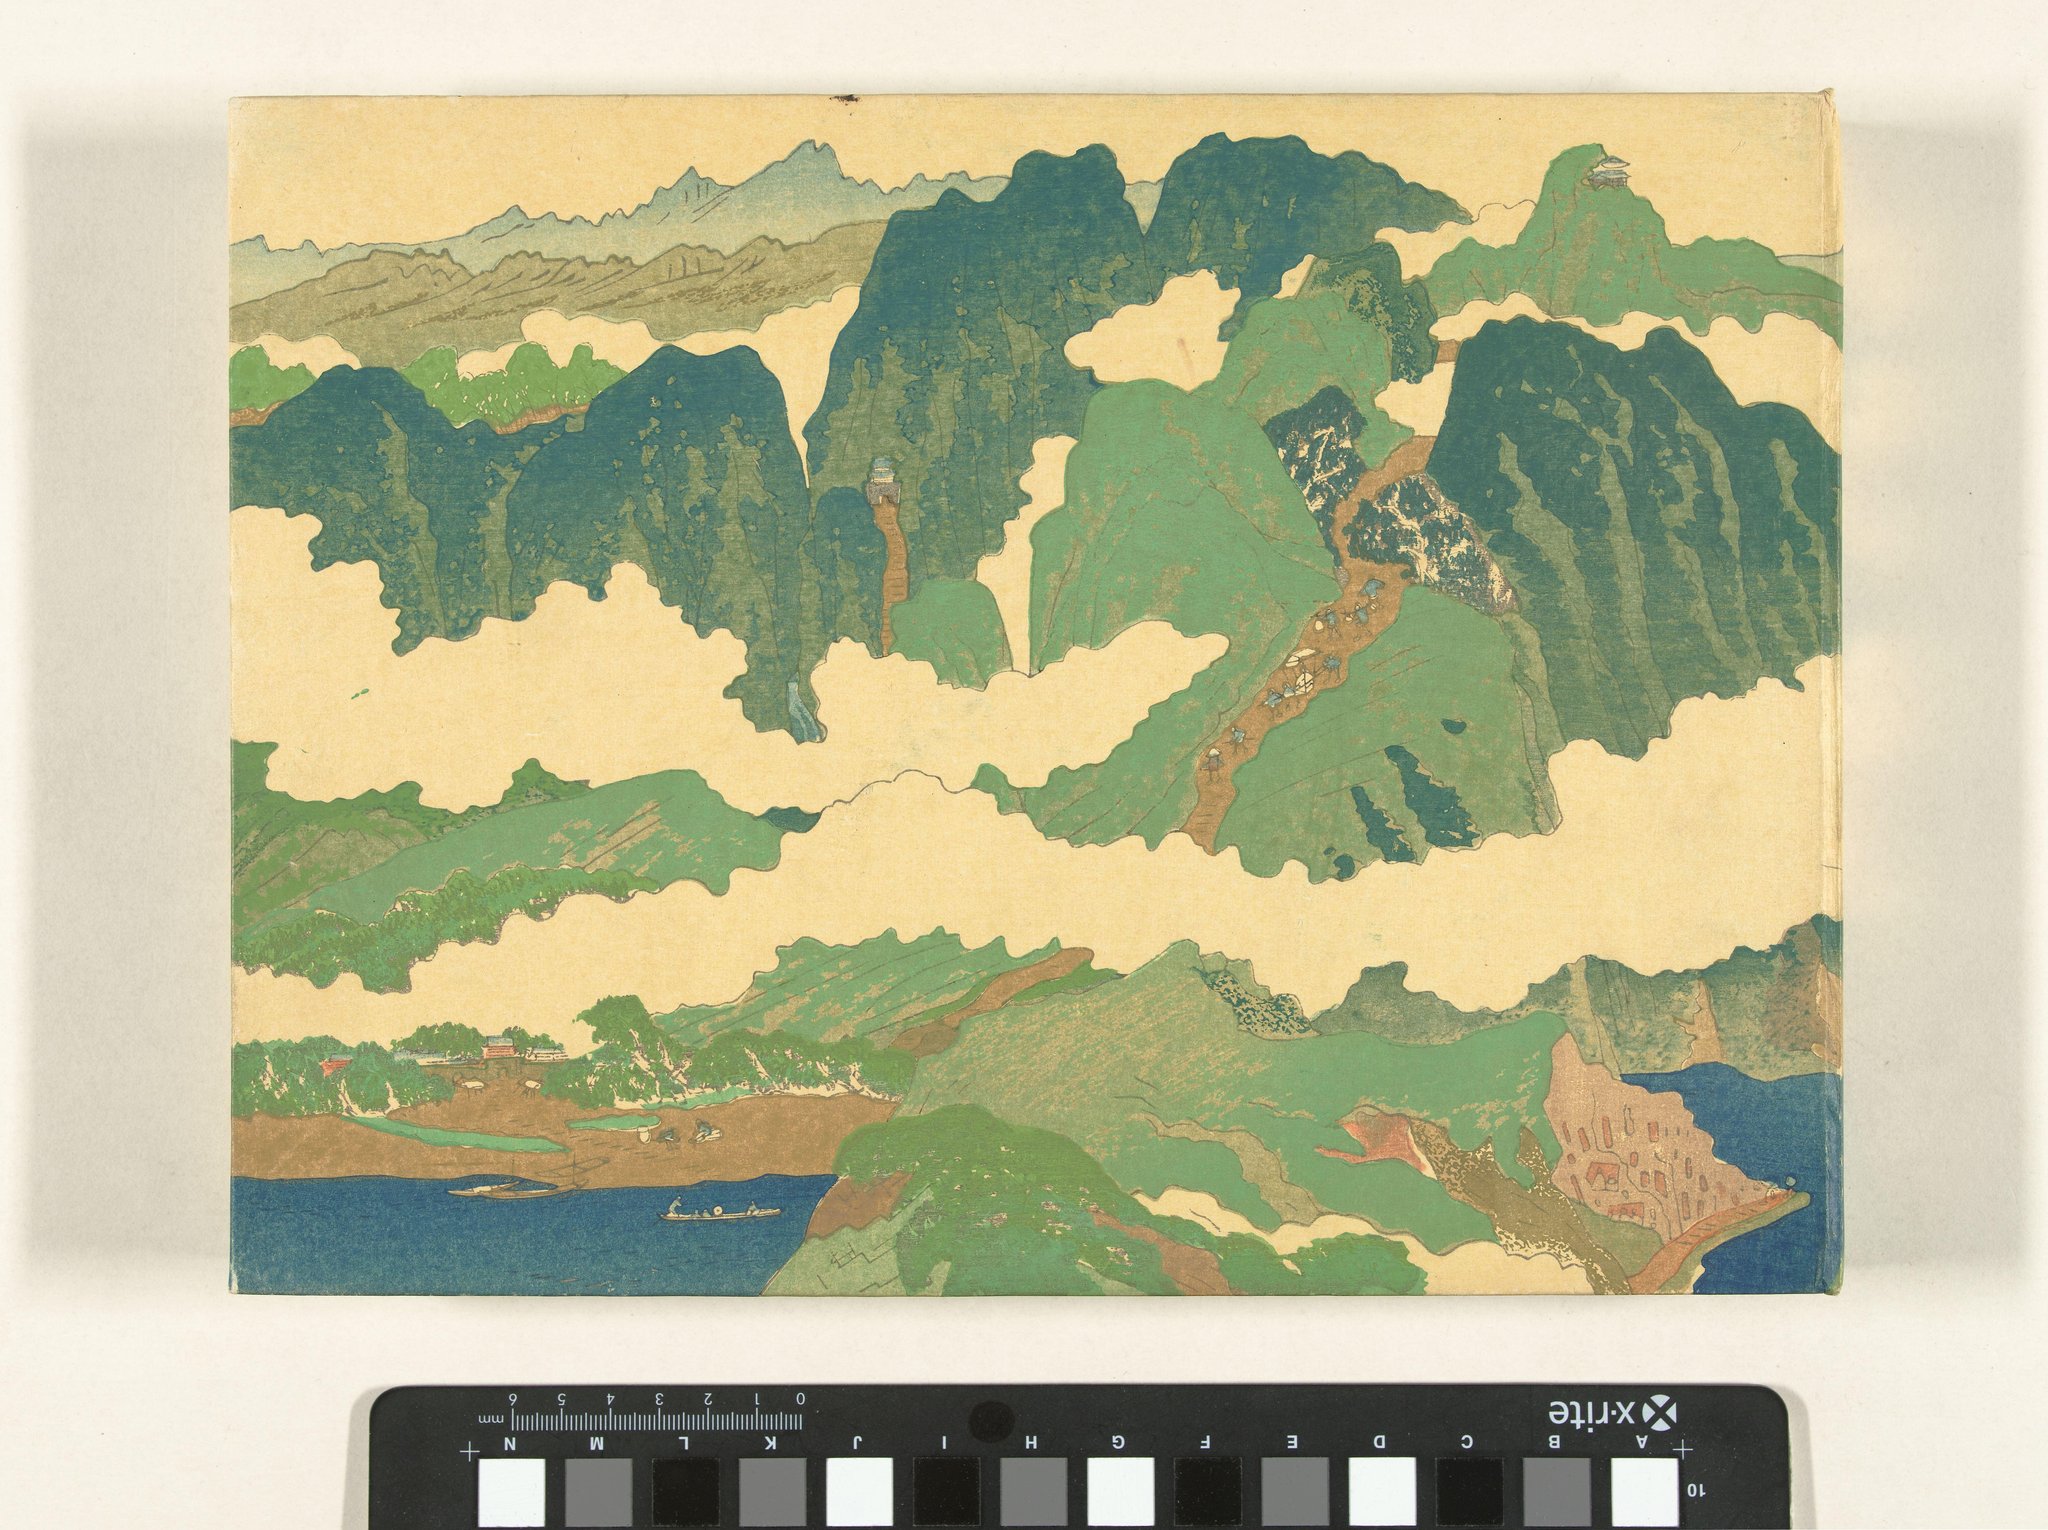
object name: book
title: Yosuko no maki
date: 1916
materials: paper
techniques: woodcut, letterpress printing, planographic printing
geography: tokyo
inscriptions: date